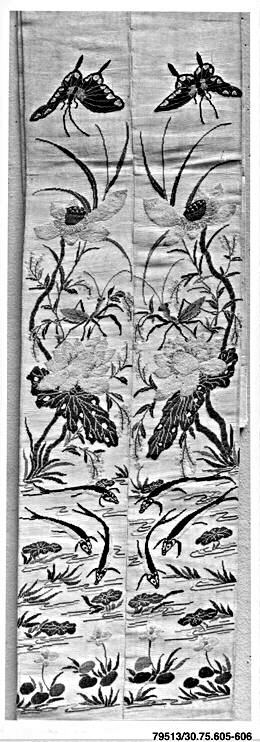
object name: sleeve band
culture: chinese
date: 1801-1900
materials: silk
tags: fish,insects,butterflies